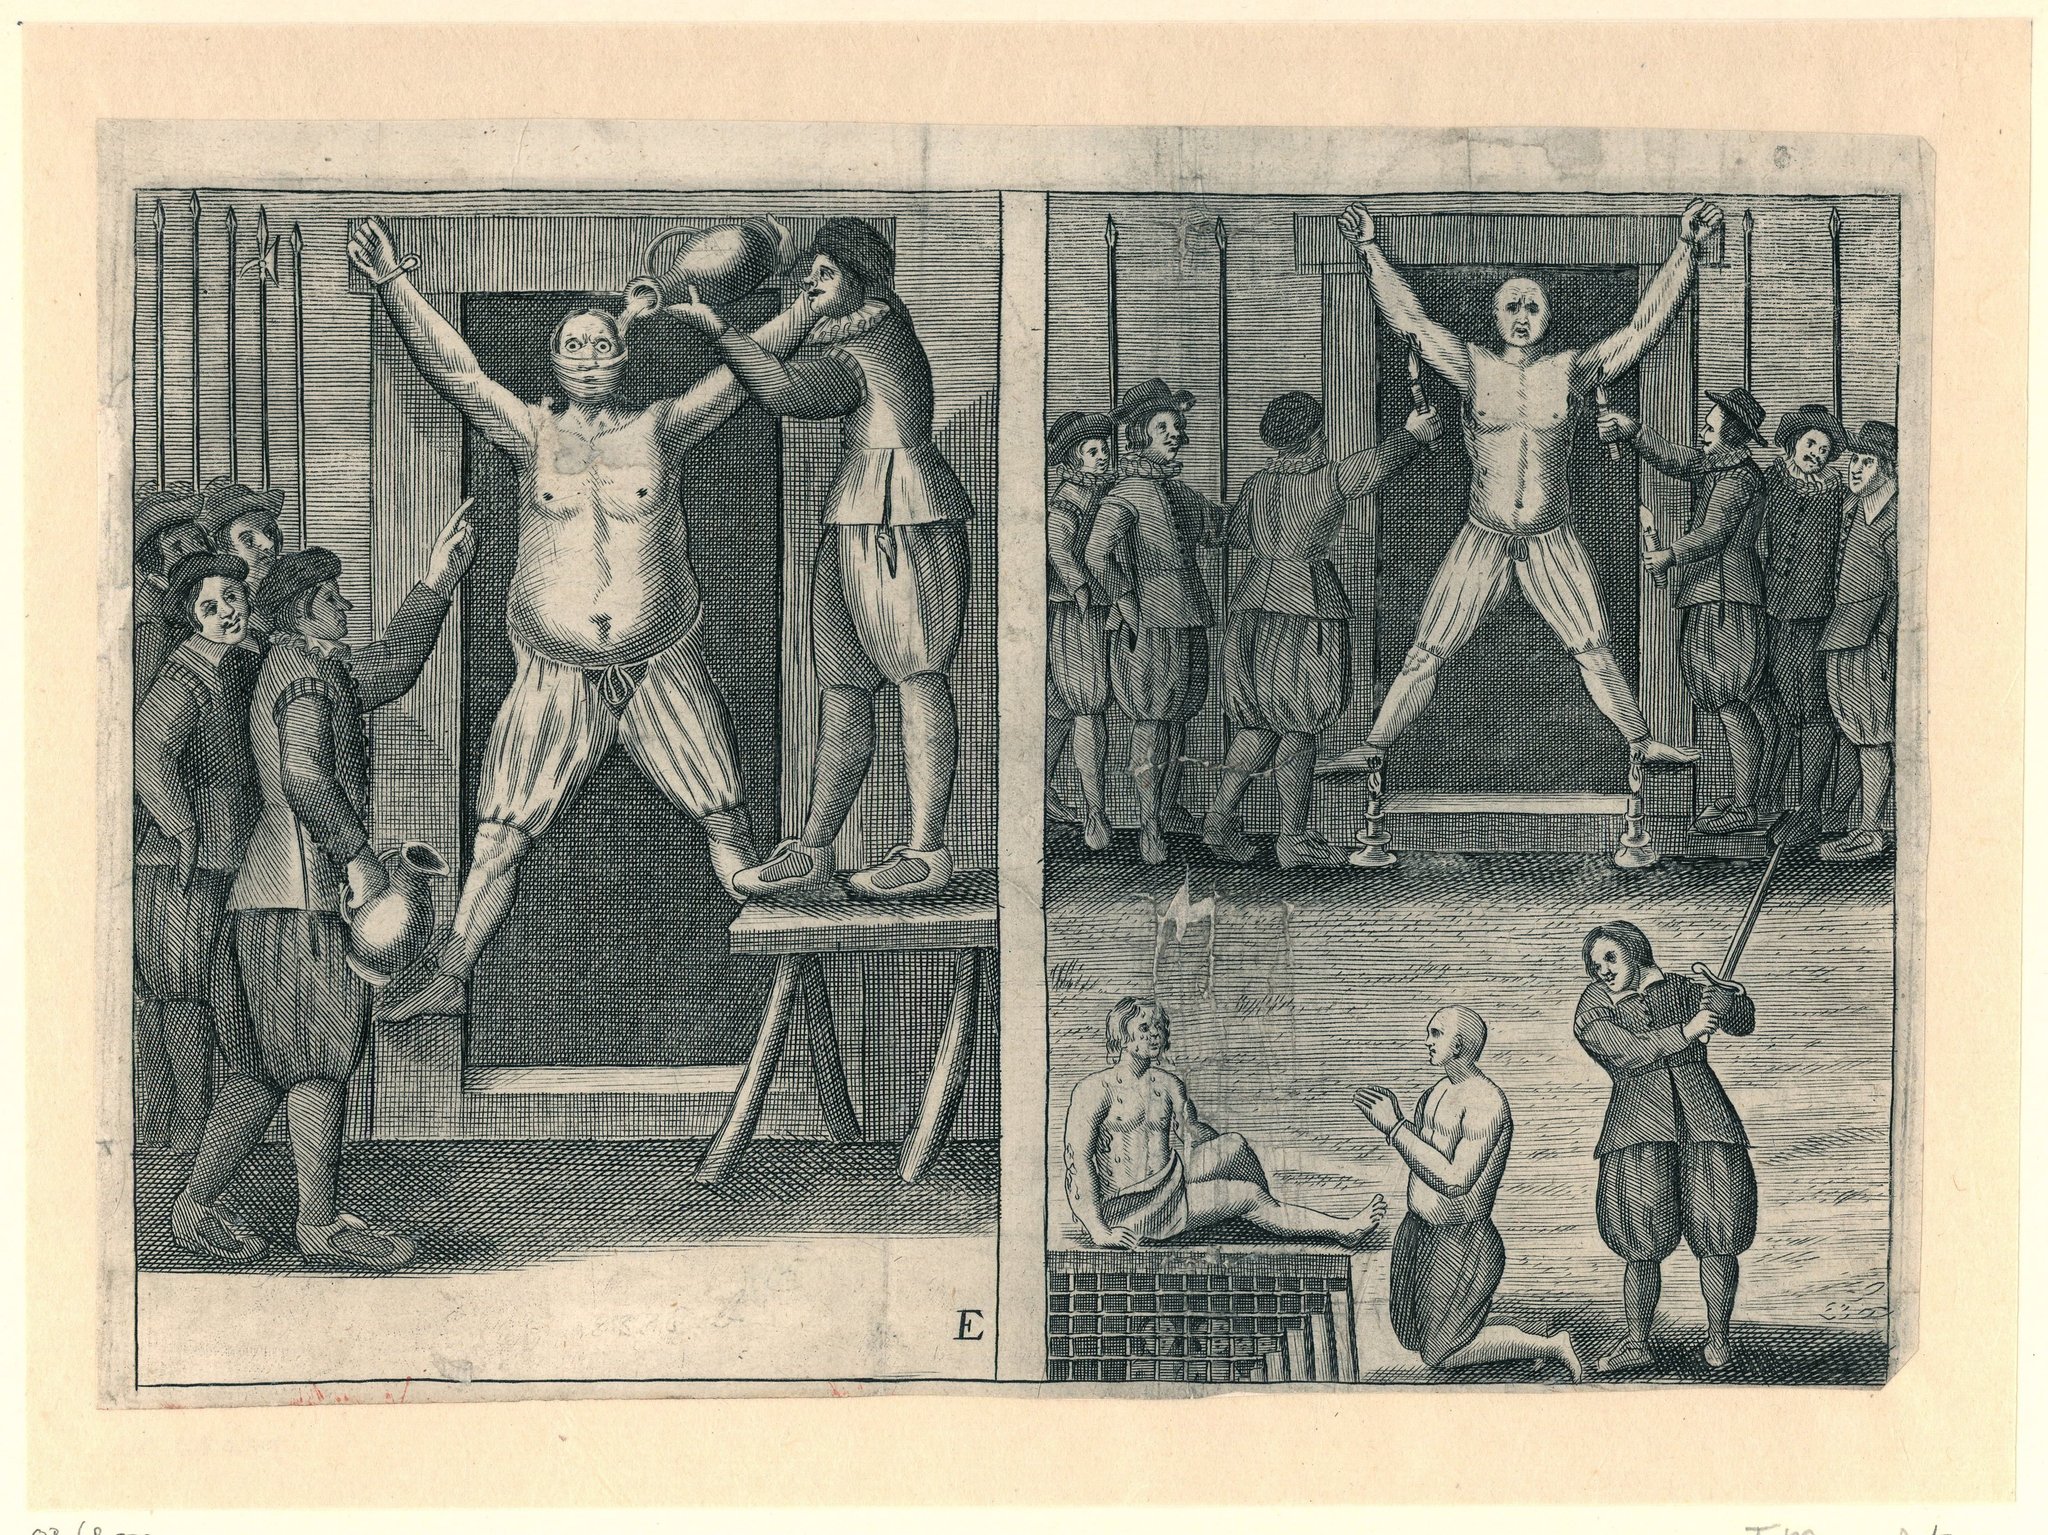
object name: print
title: De martelingen van de Engelsen door de Hollanders op Ambon in 1622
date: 1673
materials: paper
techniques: engraving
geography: london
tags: torture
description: Illustratie gemerkt 'E', afkomstig uit W. Stubbe, 'A Further Justification of the Present War against the United Netherlands', Londen 1673. De voorstelling toont de martelingen van de Engelsen door de Hollanders op Ambon in 1622. Links wordt een man volgegoten met water; rechts wordt een man met brandende kaarsen gepijnigd. De prenten zijn door de Engelsen gebruikt als propaganda om de oorlog tegen de Verenigde Provincies te rechtvaardigen.